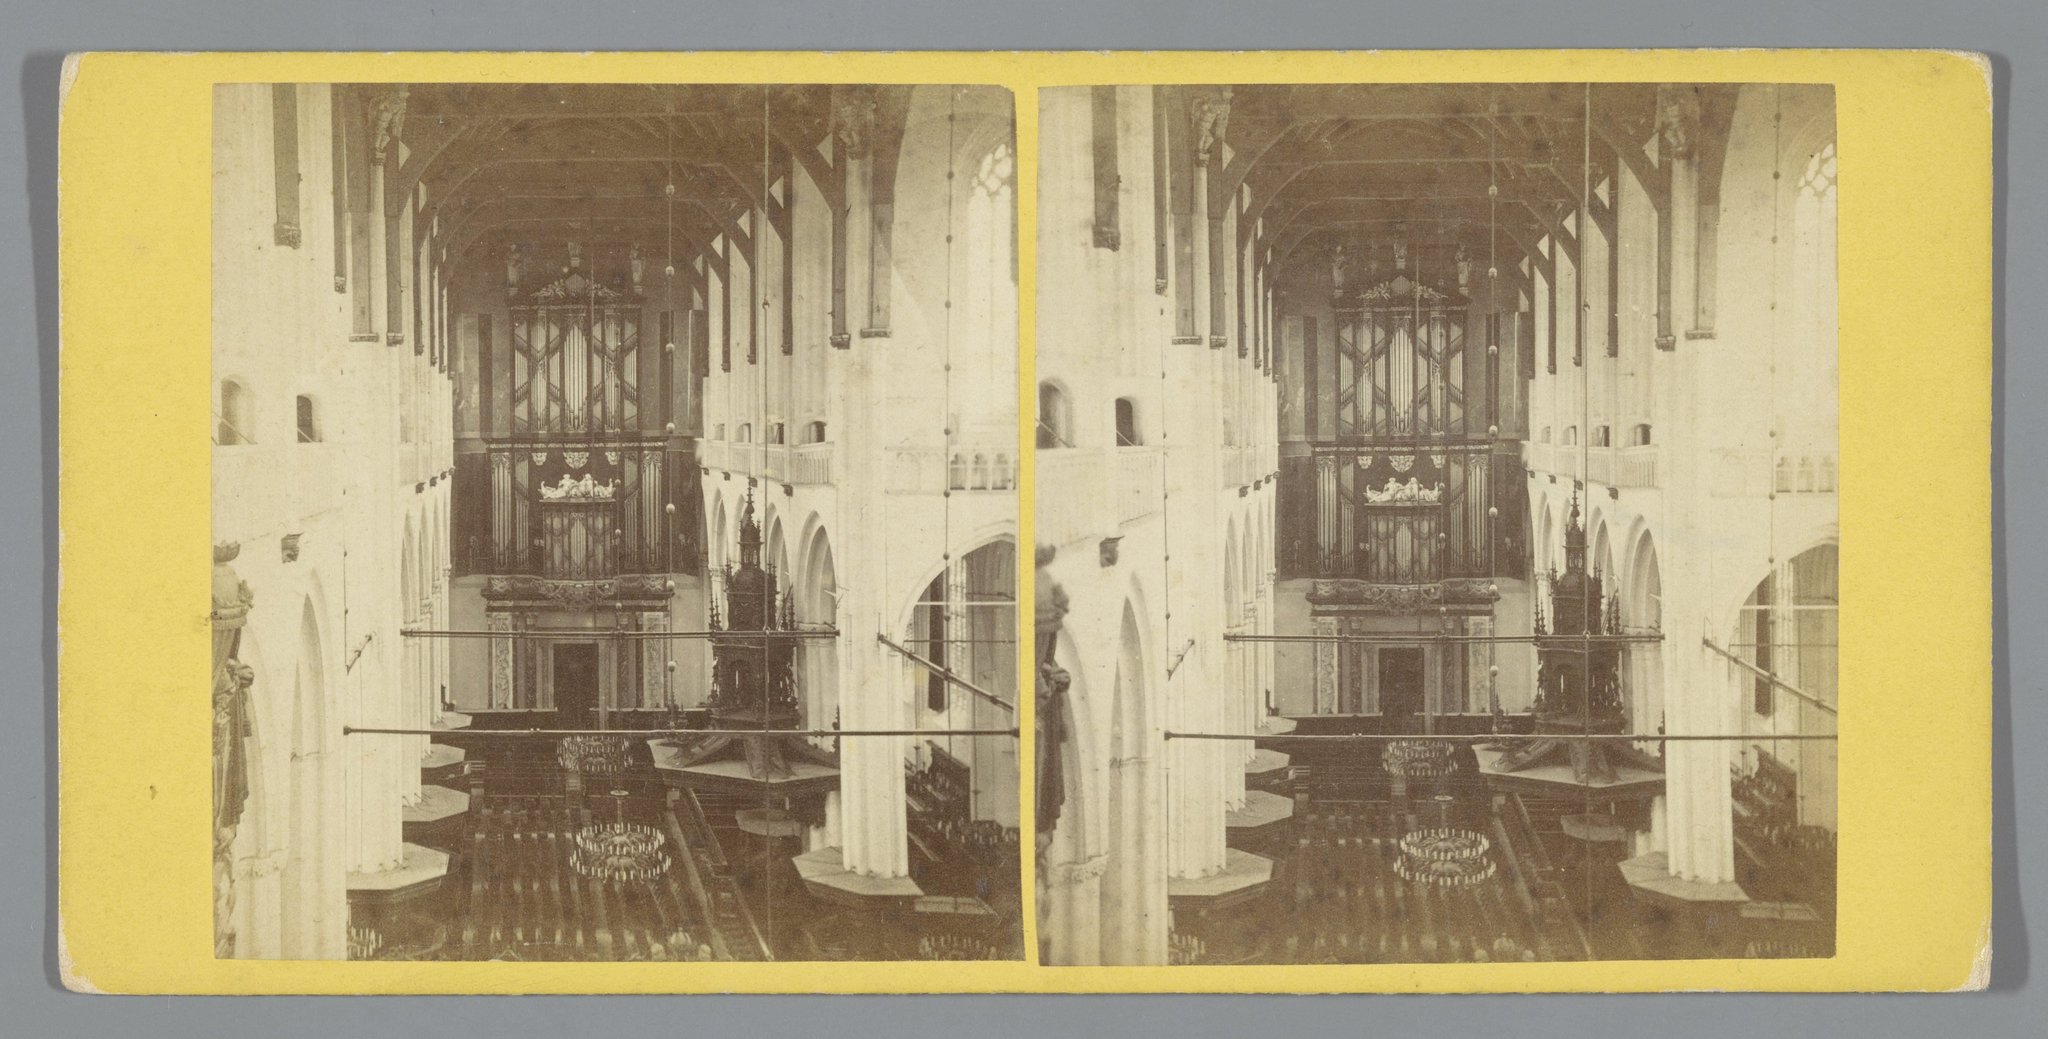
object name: stereograph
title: Gezicht op het interieur van de Nieuwe Kerk in Amsterdam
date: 1860-1885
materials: cardboard, photographic support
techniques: albumen print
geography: amsterdam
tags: parts of church interior: nave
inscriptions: inscription: ‘DE NIEUWE KERK TE AMSTERDAM./ (...) Uitgave van A. JAGER, Water 110, te Amsterdam.’